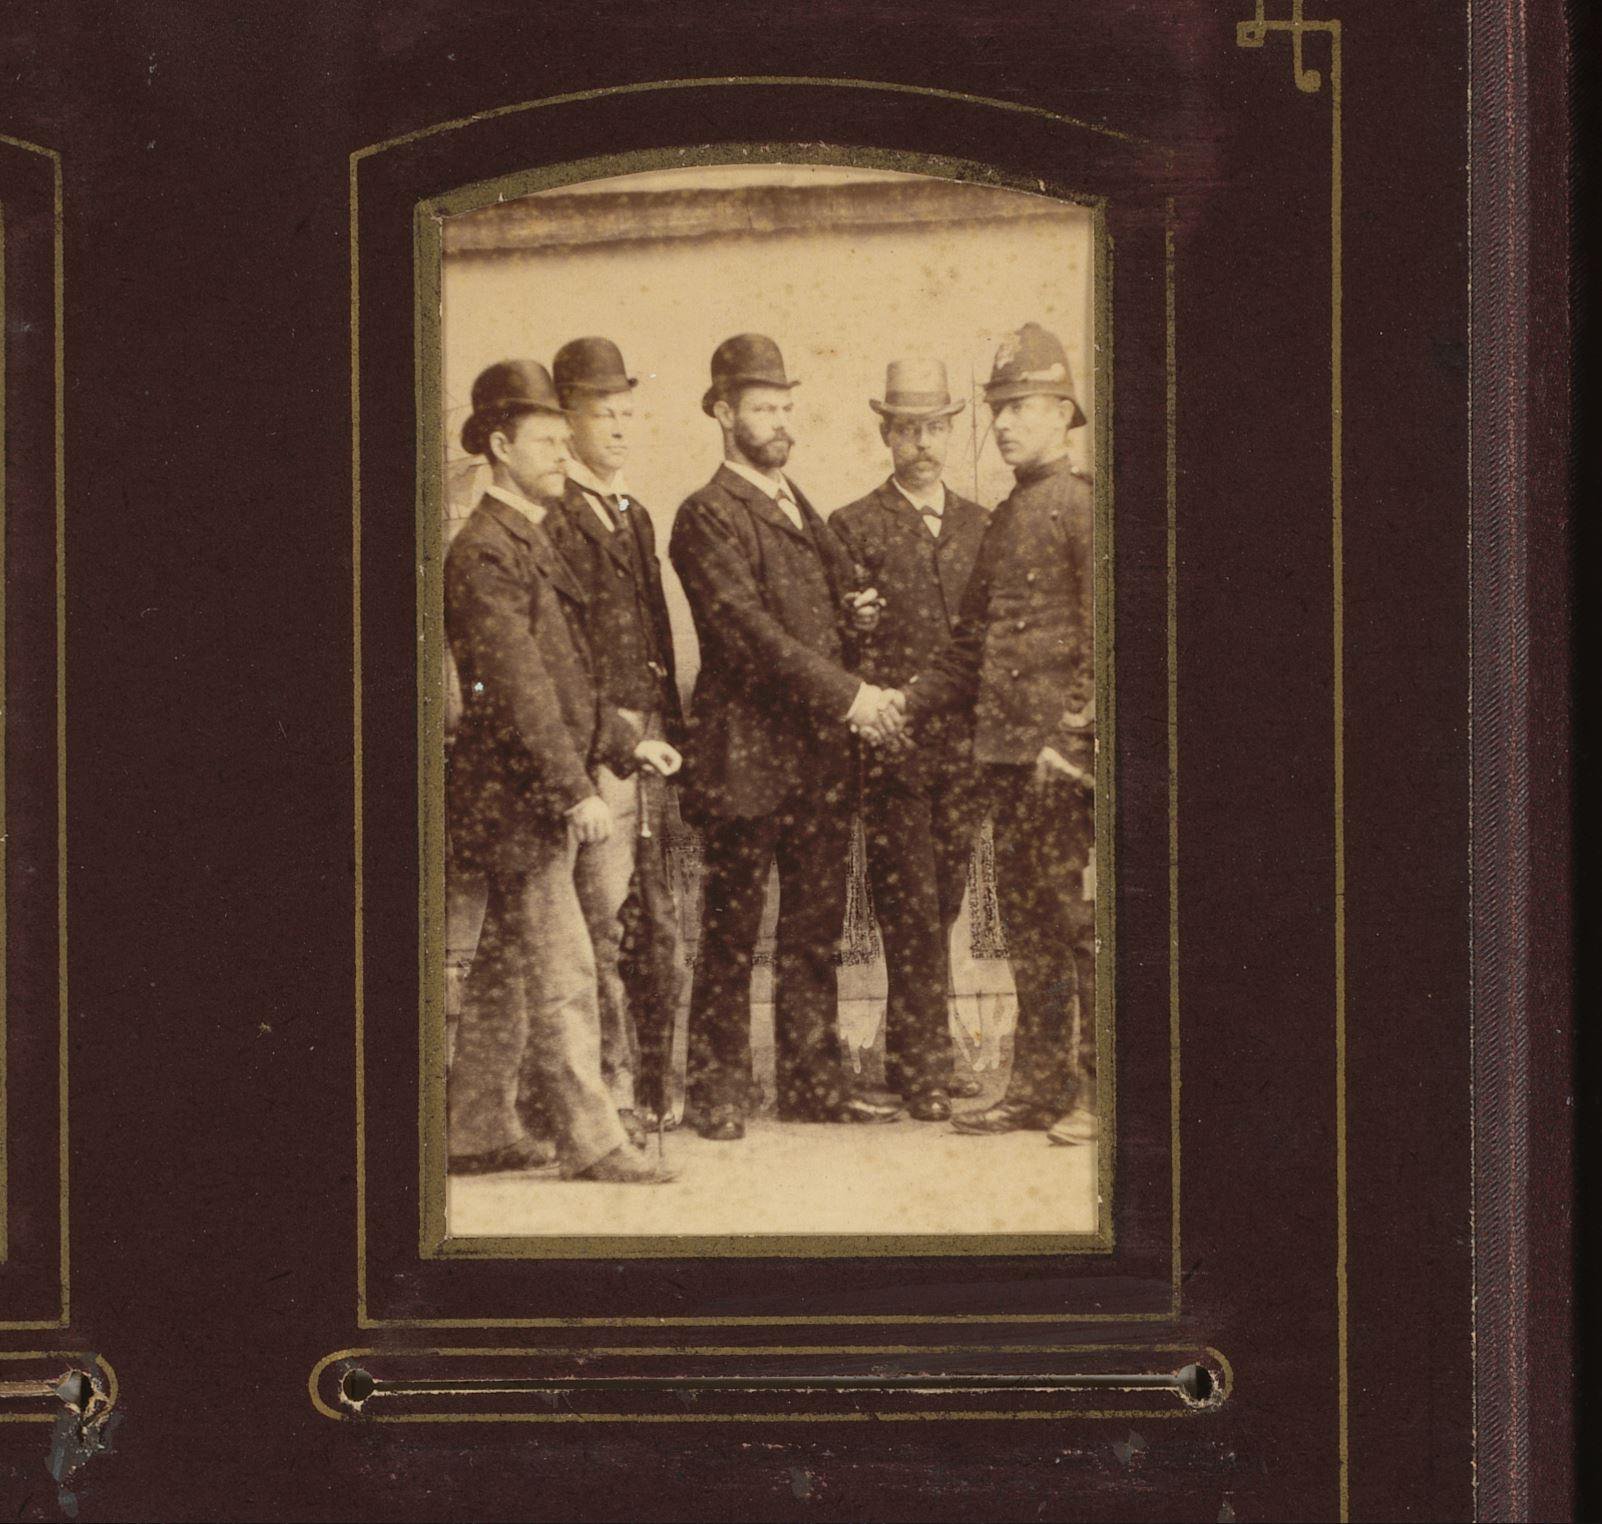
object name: photograph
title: Portret van vijf mannen, waarvan één agent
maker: hendrik boonstoppel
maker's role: fotograaf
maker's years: 1854-1924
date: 1880-1901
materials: cardboard, photographic support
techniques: albumen print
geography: dordrecht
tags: adult man (+ five persons), policeman, constable, anonymous historical persons portrayed in a group, in a group-portrait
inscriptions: inscription: ‘Photographie/ Instantanée/ H. Boonstoppel/ regt over/ het Postkantoor/ naast het verkooplokaal/ et Dordrecht/ Portretten kunnen op iedere groote nabesteld worden.’